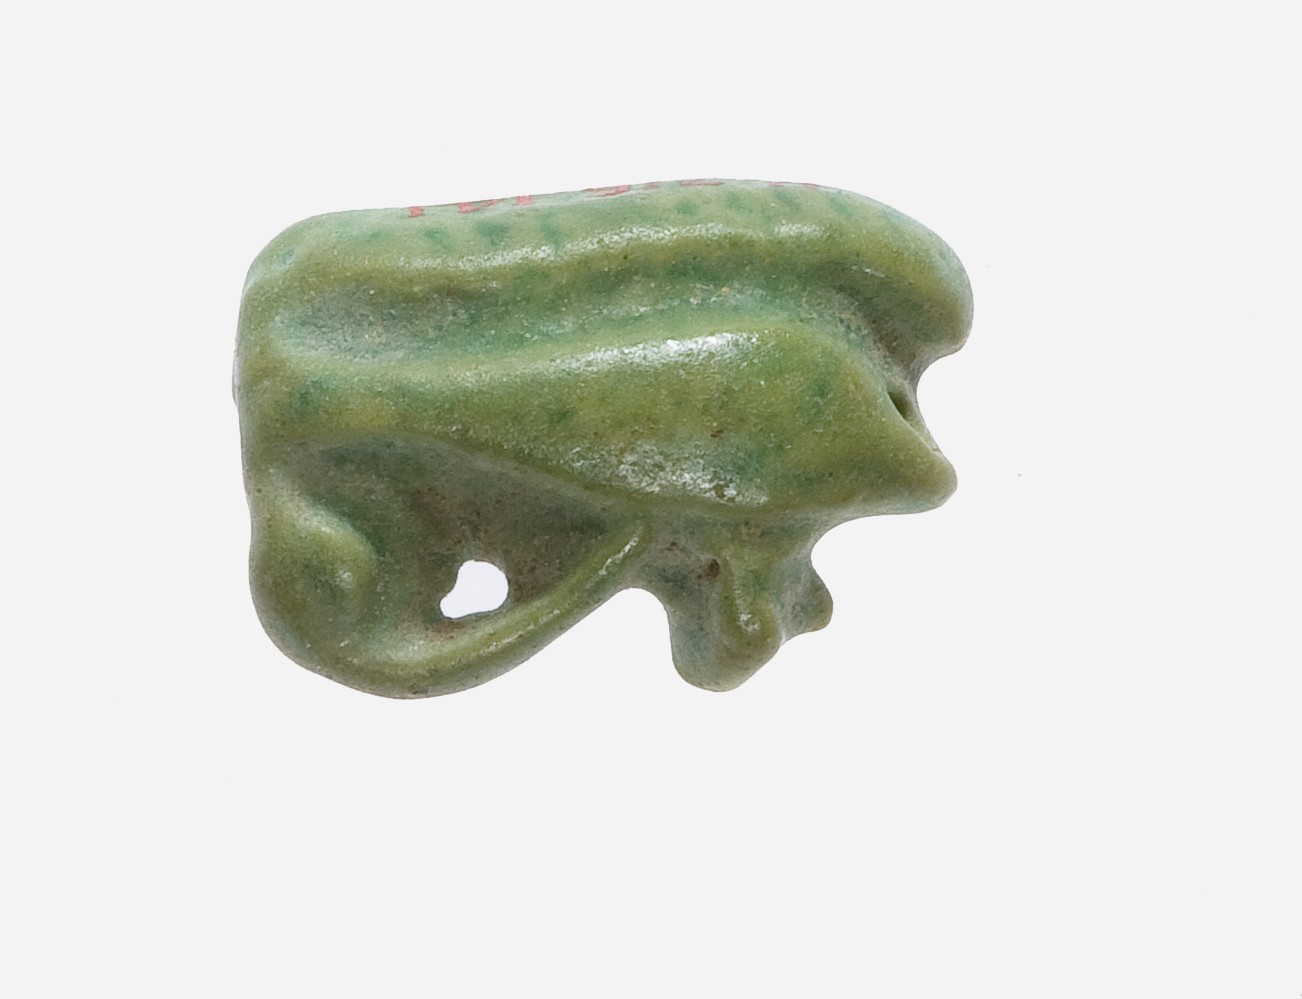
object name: amulet, wedjat eye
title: Wedjat Eye Amulet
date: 1390-1352 BCE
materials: faience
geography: egypt